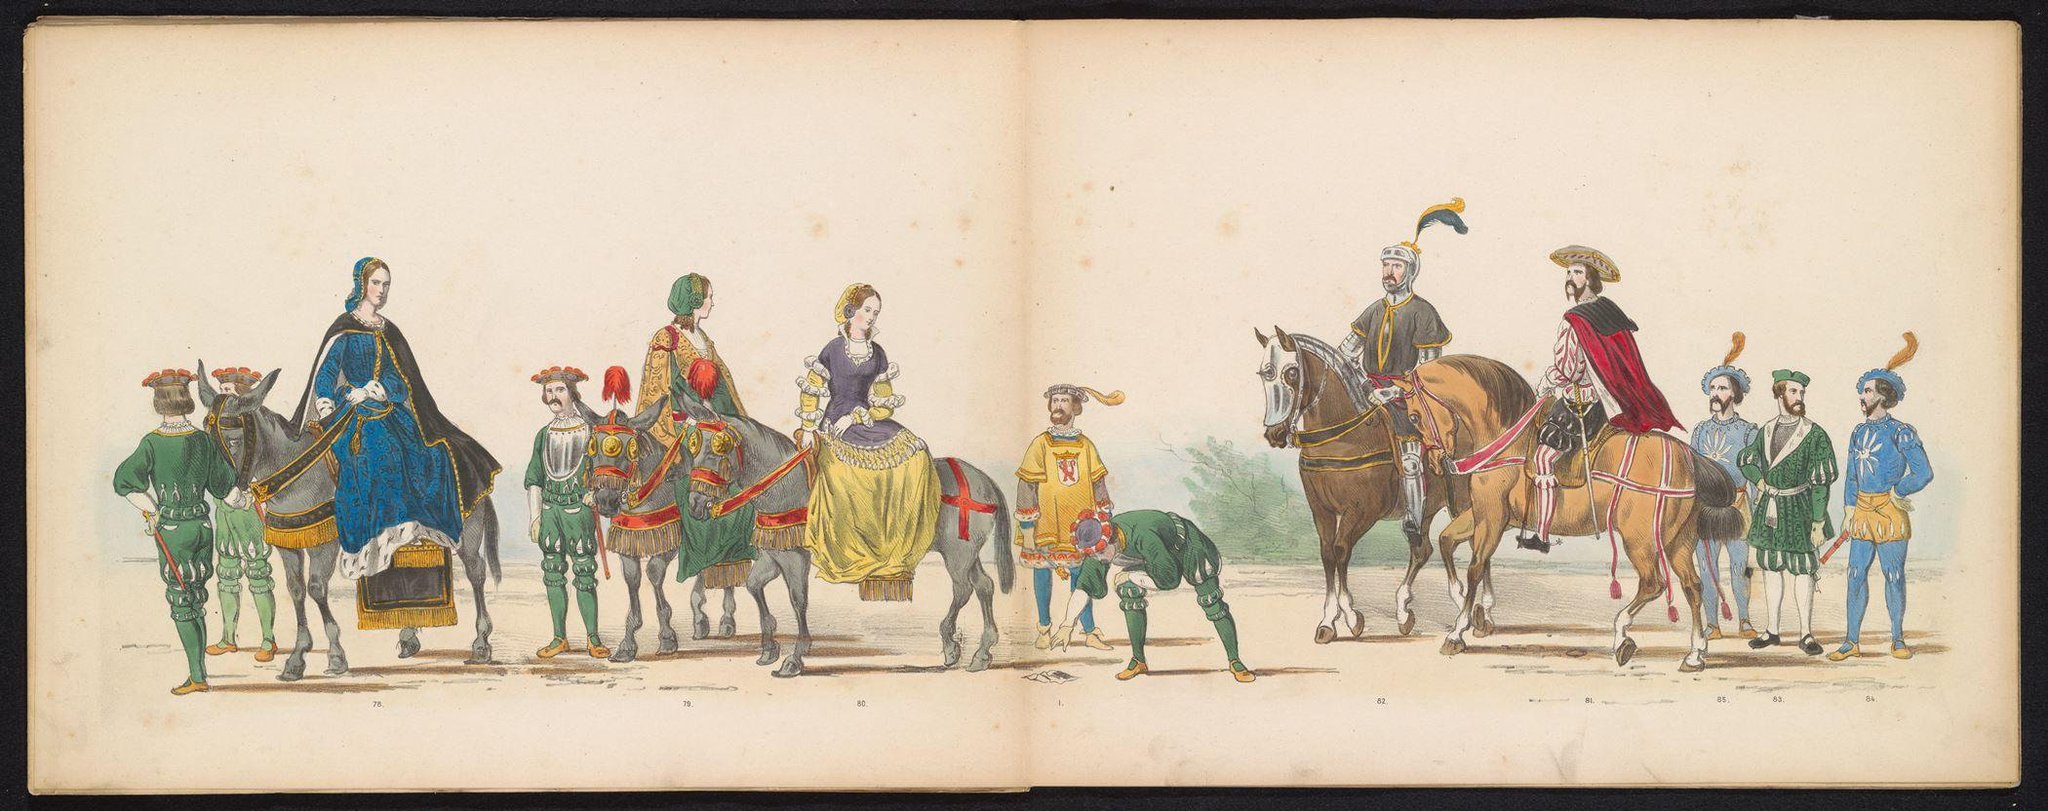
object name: print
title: Maskerade van de Leidse studenten, 1855 (plaat 10)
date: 1855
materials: paper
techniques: hand coloring, lithograph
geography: leiden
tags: ghent, charles v (holy roman emperor and king of spain), students' pageant, costumes used in pageants, leiden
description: Historische gekostumeerde optocht van de studenten van de Hogeschool van Leiden op 12 juni 1855 ter gelegenheid van het 280-jarig bestaan van de Hogeschool. De optocht verbeeldt de intocht van keizer Karel V te Dordrecht op 3 juni 1515 bij zijn huldiging tot graaf van Holland. Tiende plaat met de groepen genummerd 78-84. Onderdeel van een serie van veertien aanelkaar geplakte bladen.